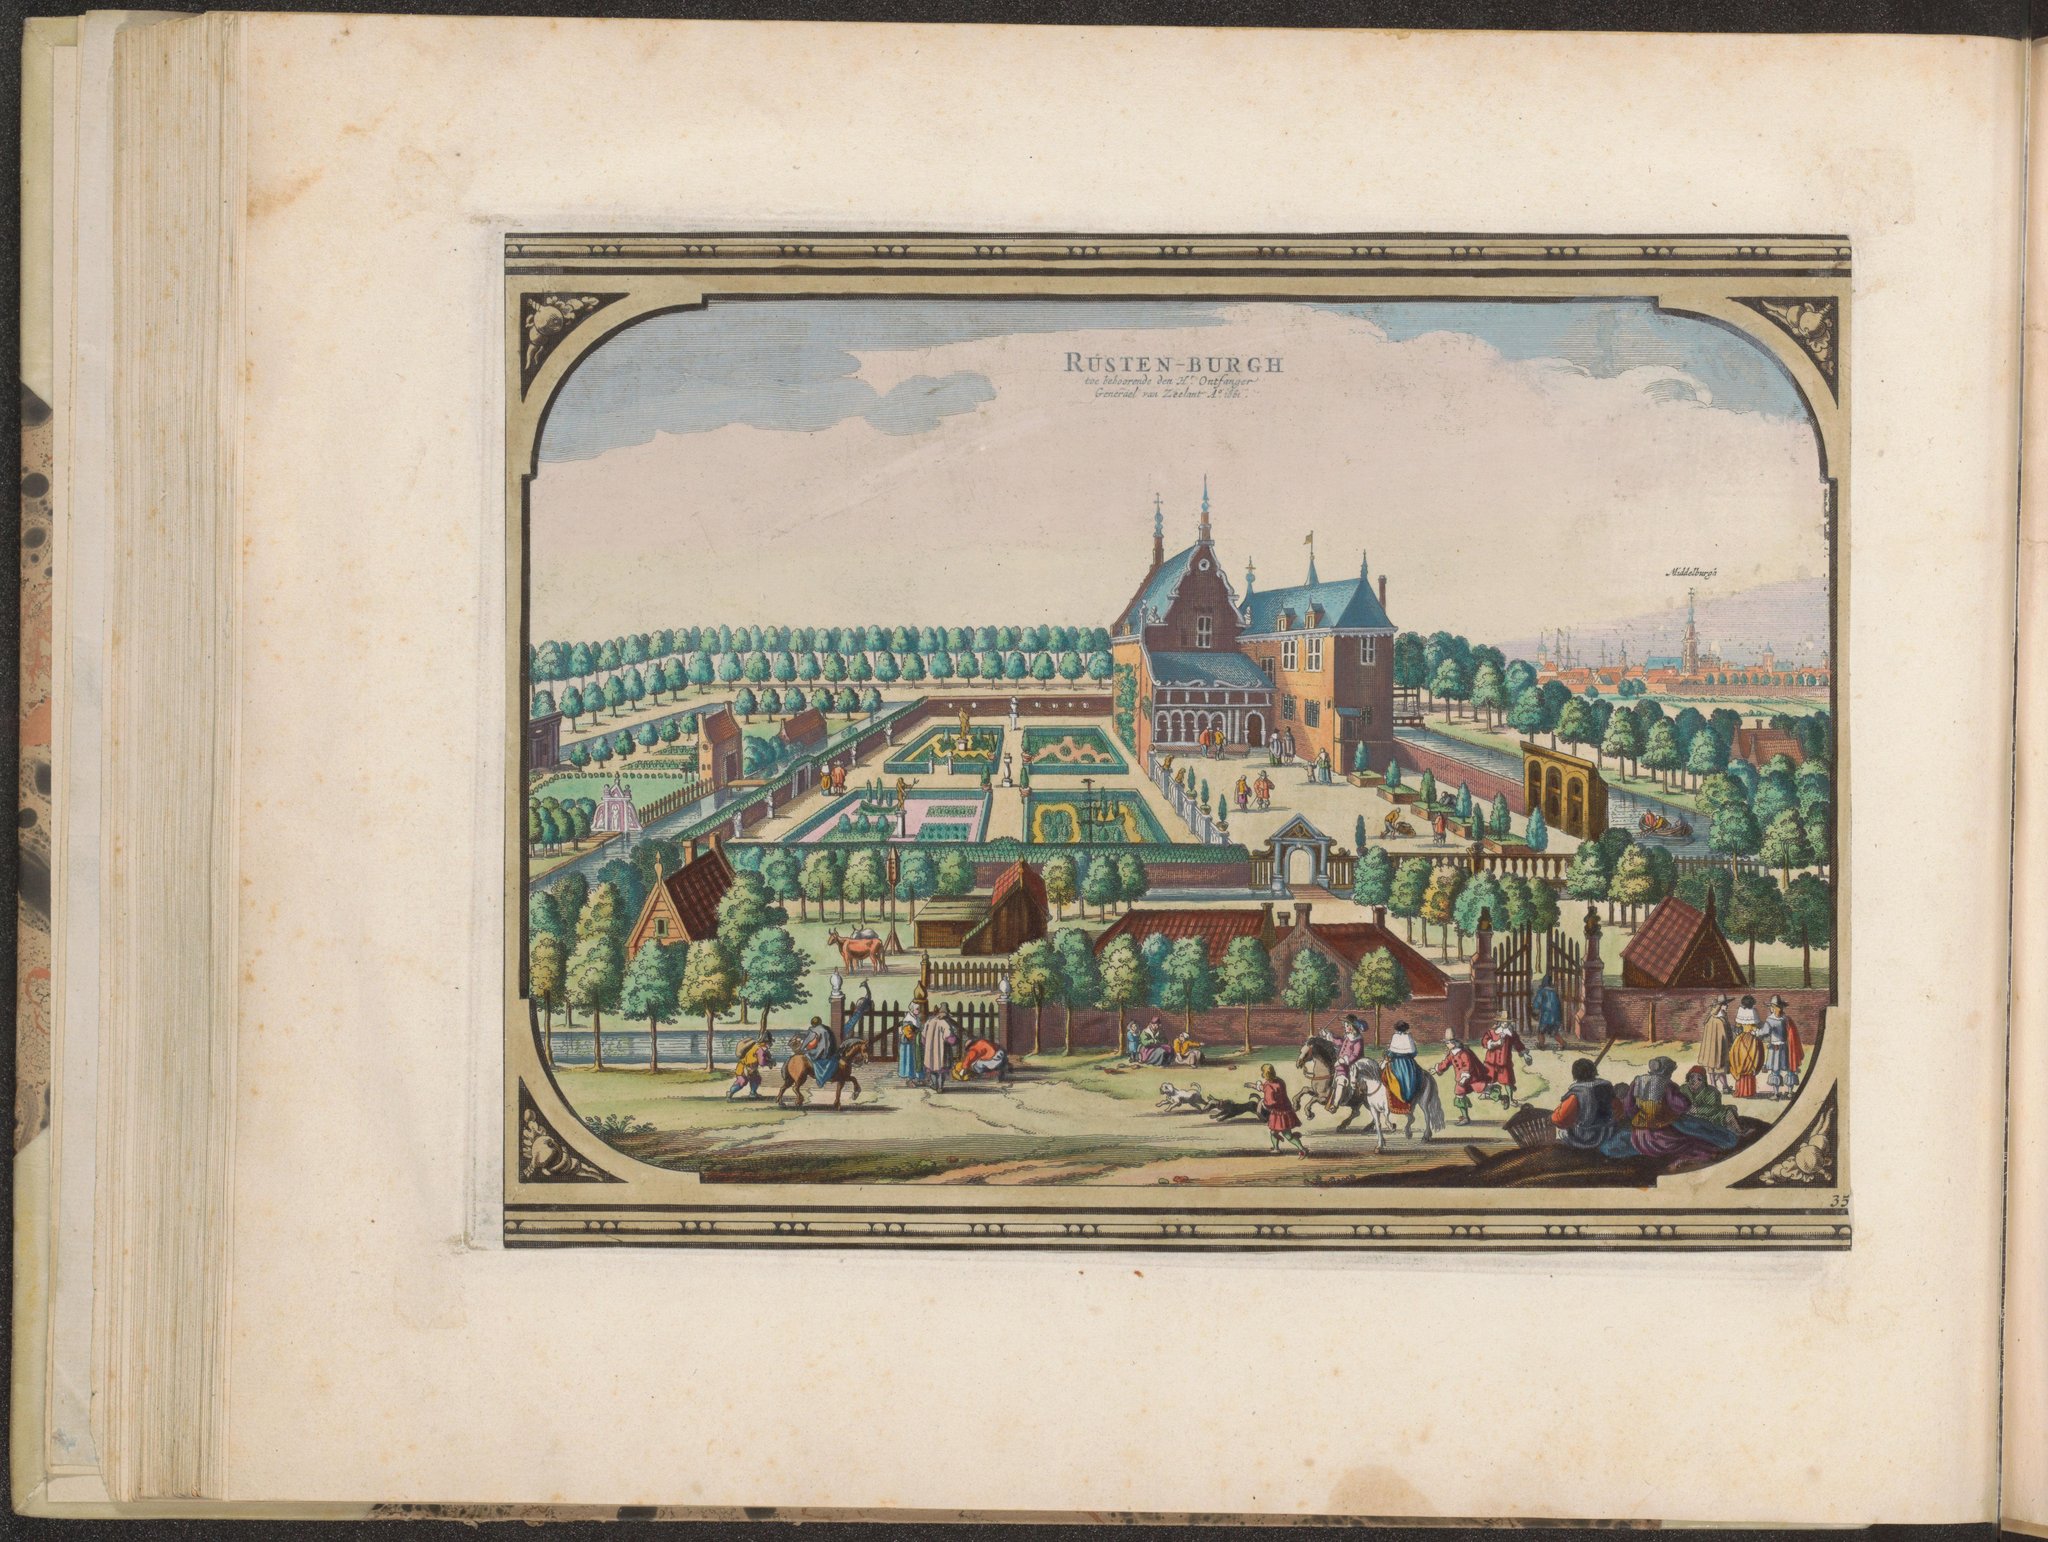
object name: album leaf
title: Speculum Zelandiae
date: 1661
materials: paper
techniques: etching, hand coloring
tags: city-view, and landscape with man-made constructions, castle, middelburg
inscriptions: date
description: Gezicht op Huis Rustenburg met in het verschiet Middelburg. De prent maakt deel uit van een album.